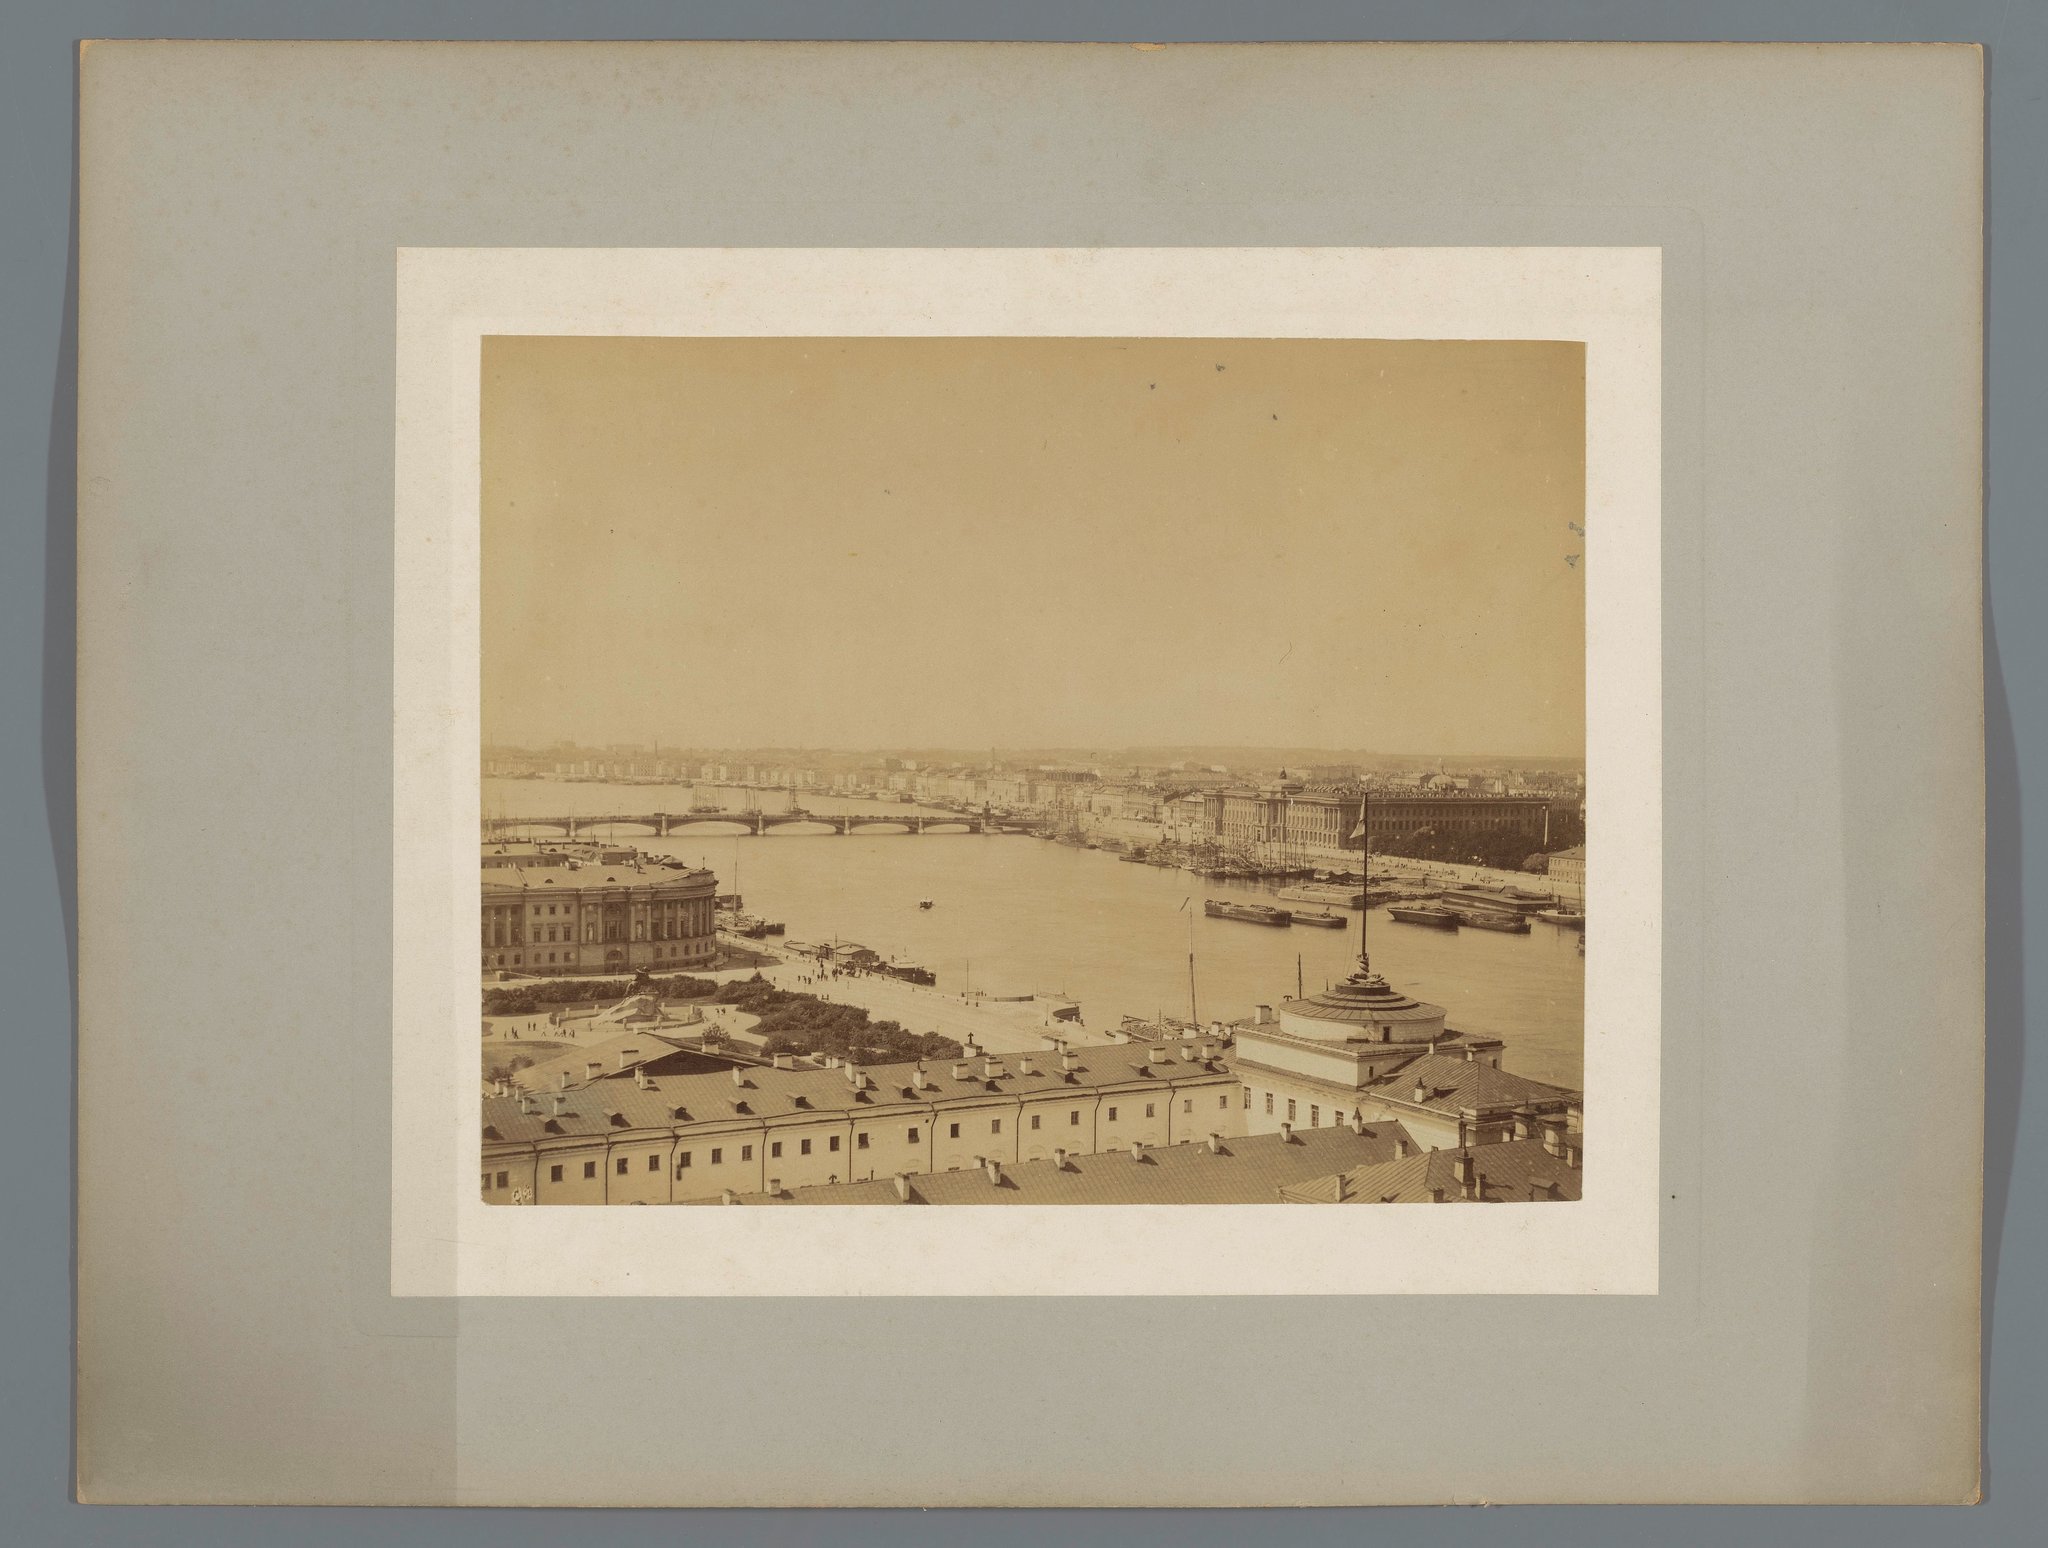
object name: photograph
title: Panorama Newa, St. Petersburg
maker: Anonymous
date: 1860-1890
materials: cardboard, paper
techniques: albumen print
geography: sint-petersburg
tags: city-view in general; 'veduta', river